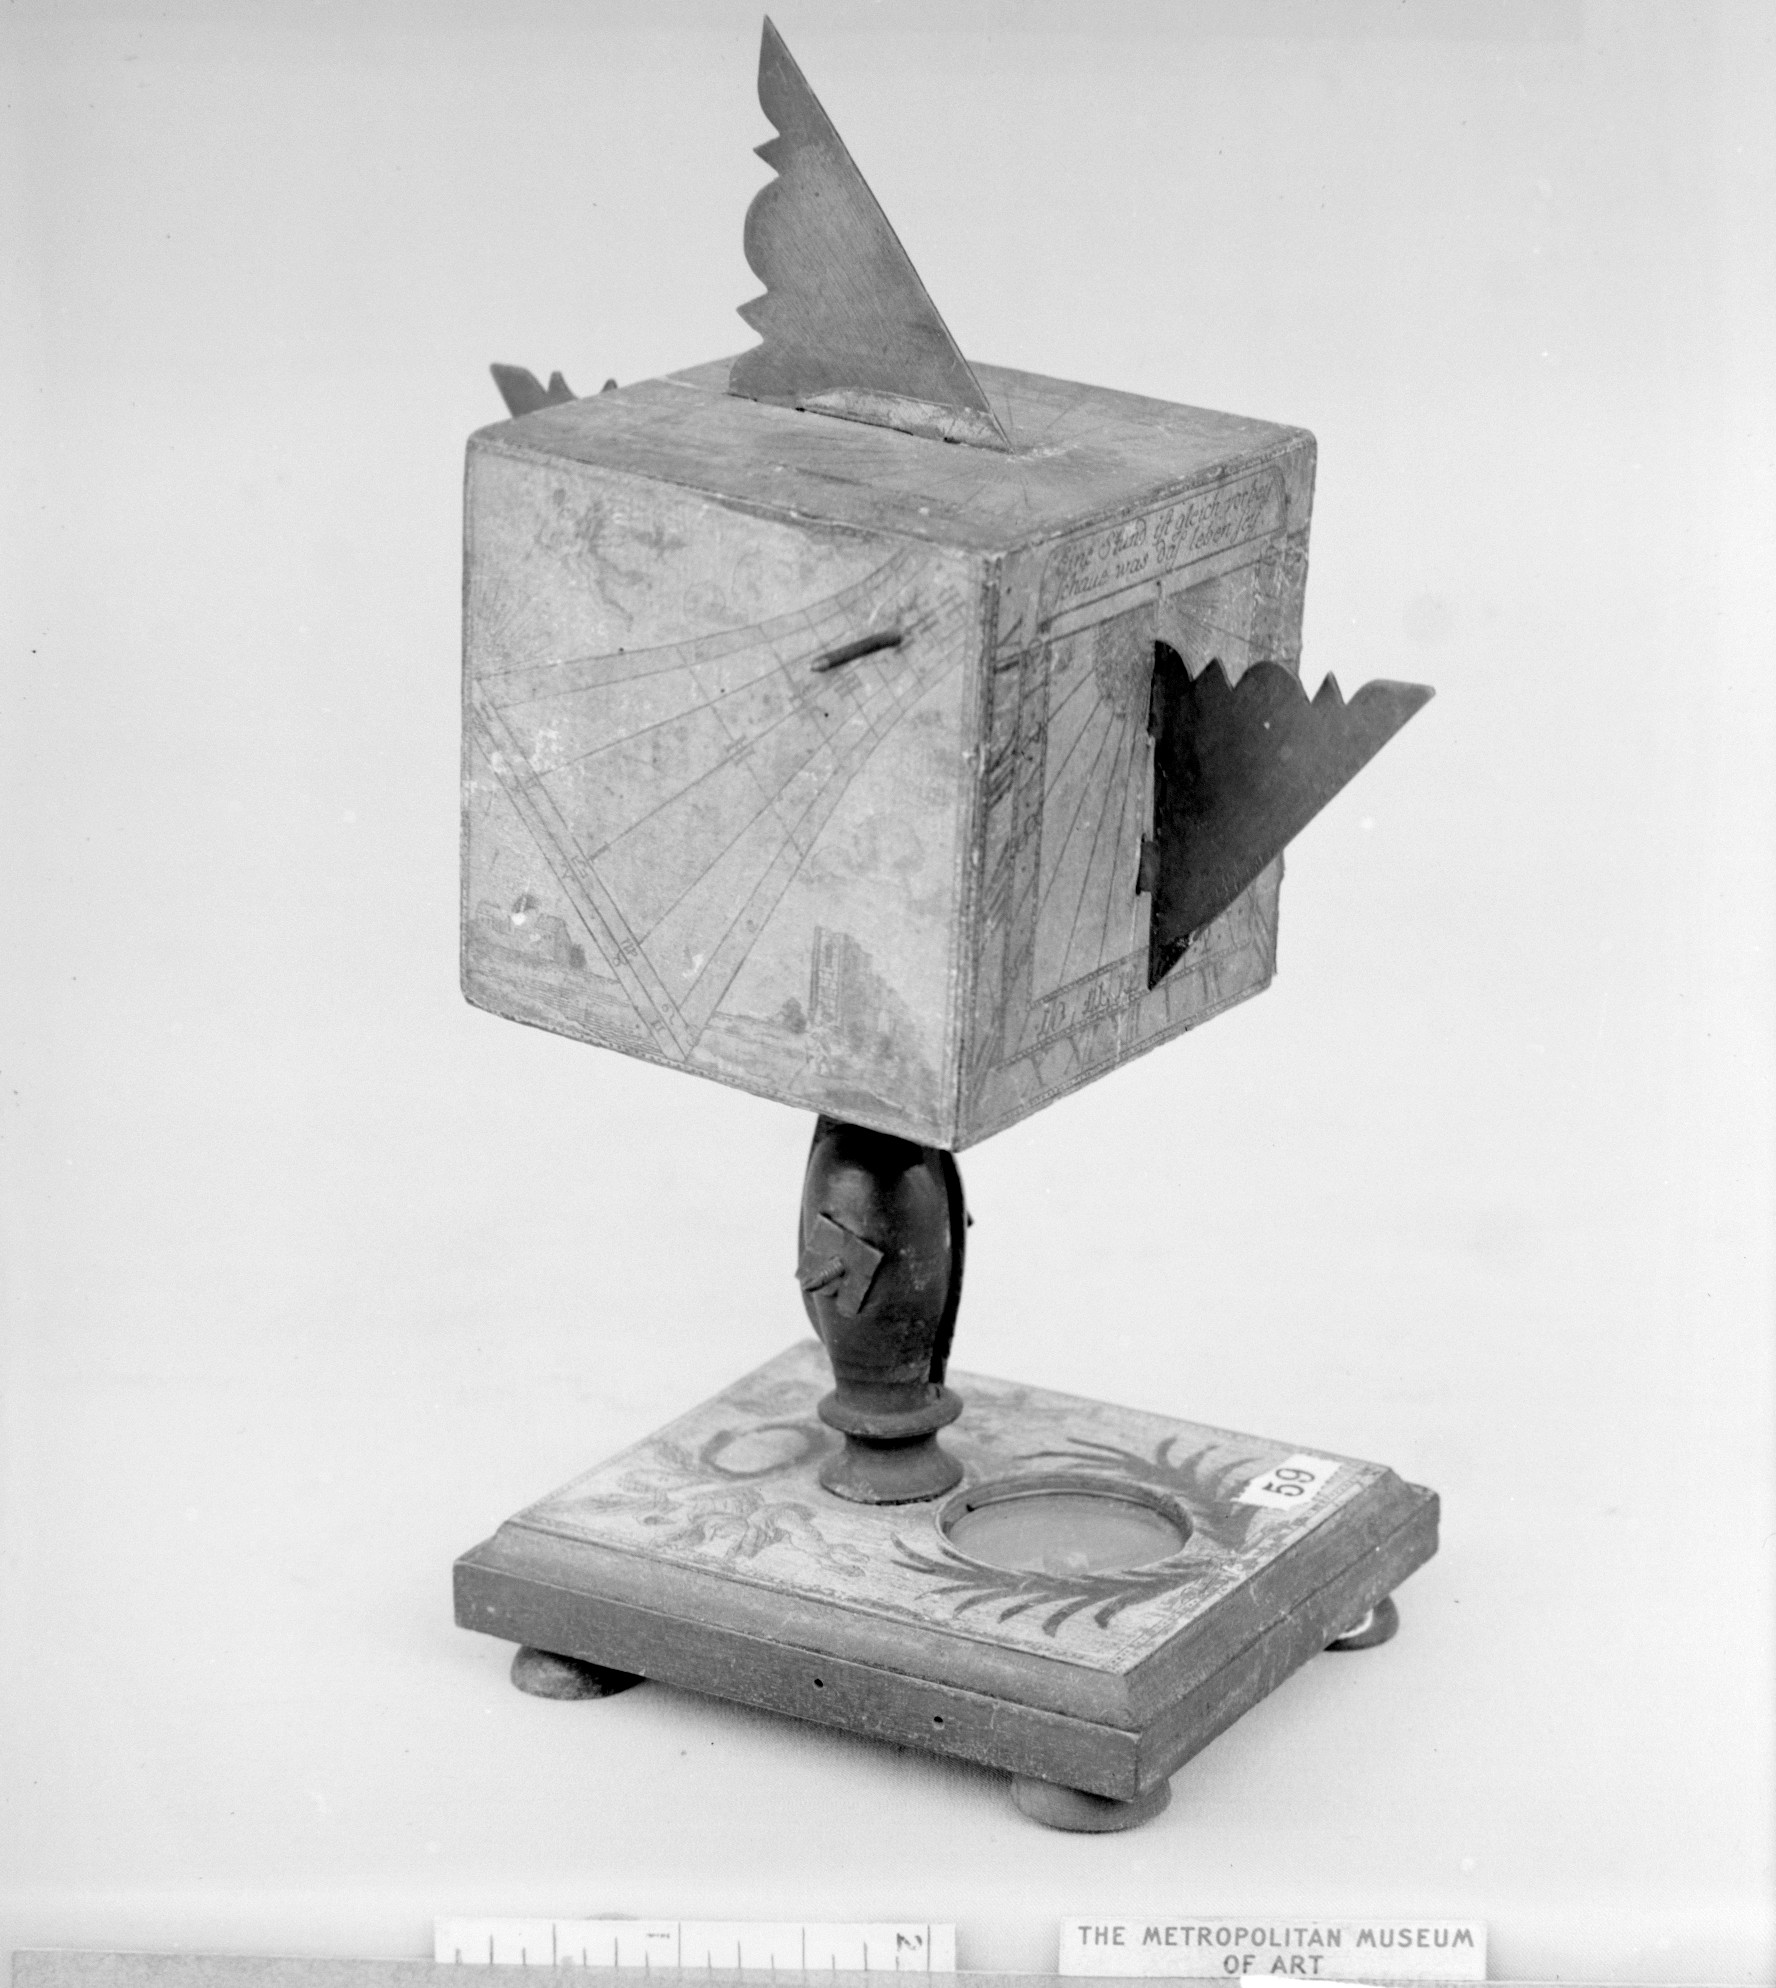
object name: portable cube sundial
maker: e.c. stockert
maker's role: maker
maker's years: 1750-1850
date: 1801-1833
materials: paper, wood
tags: sundials